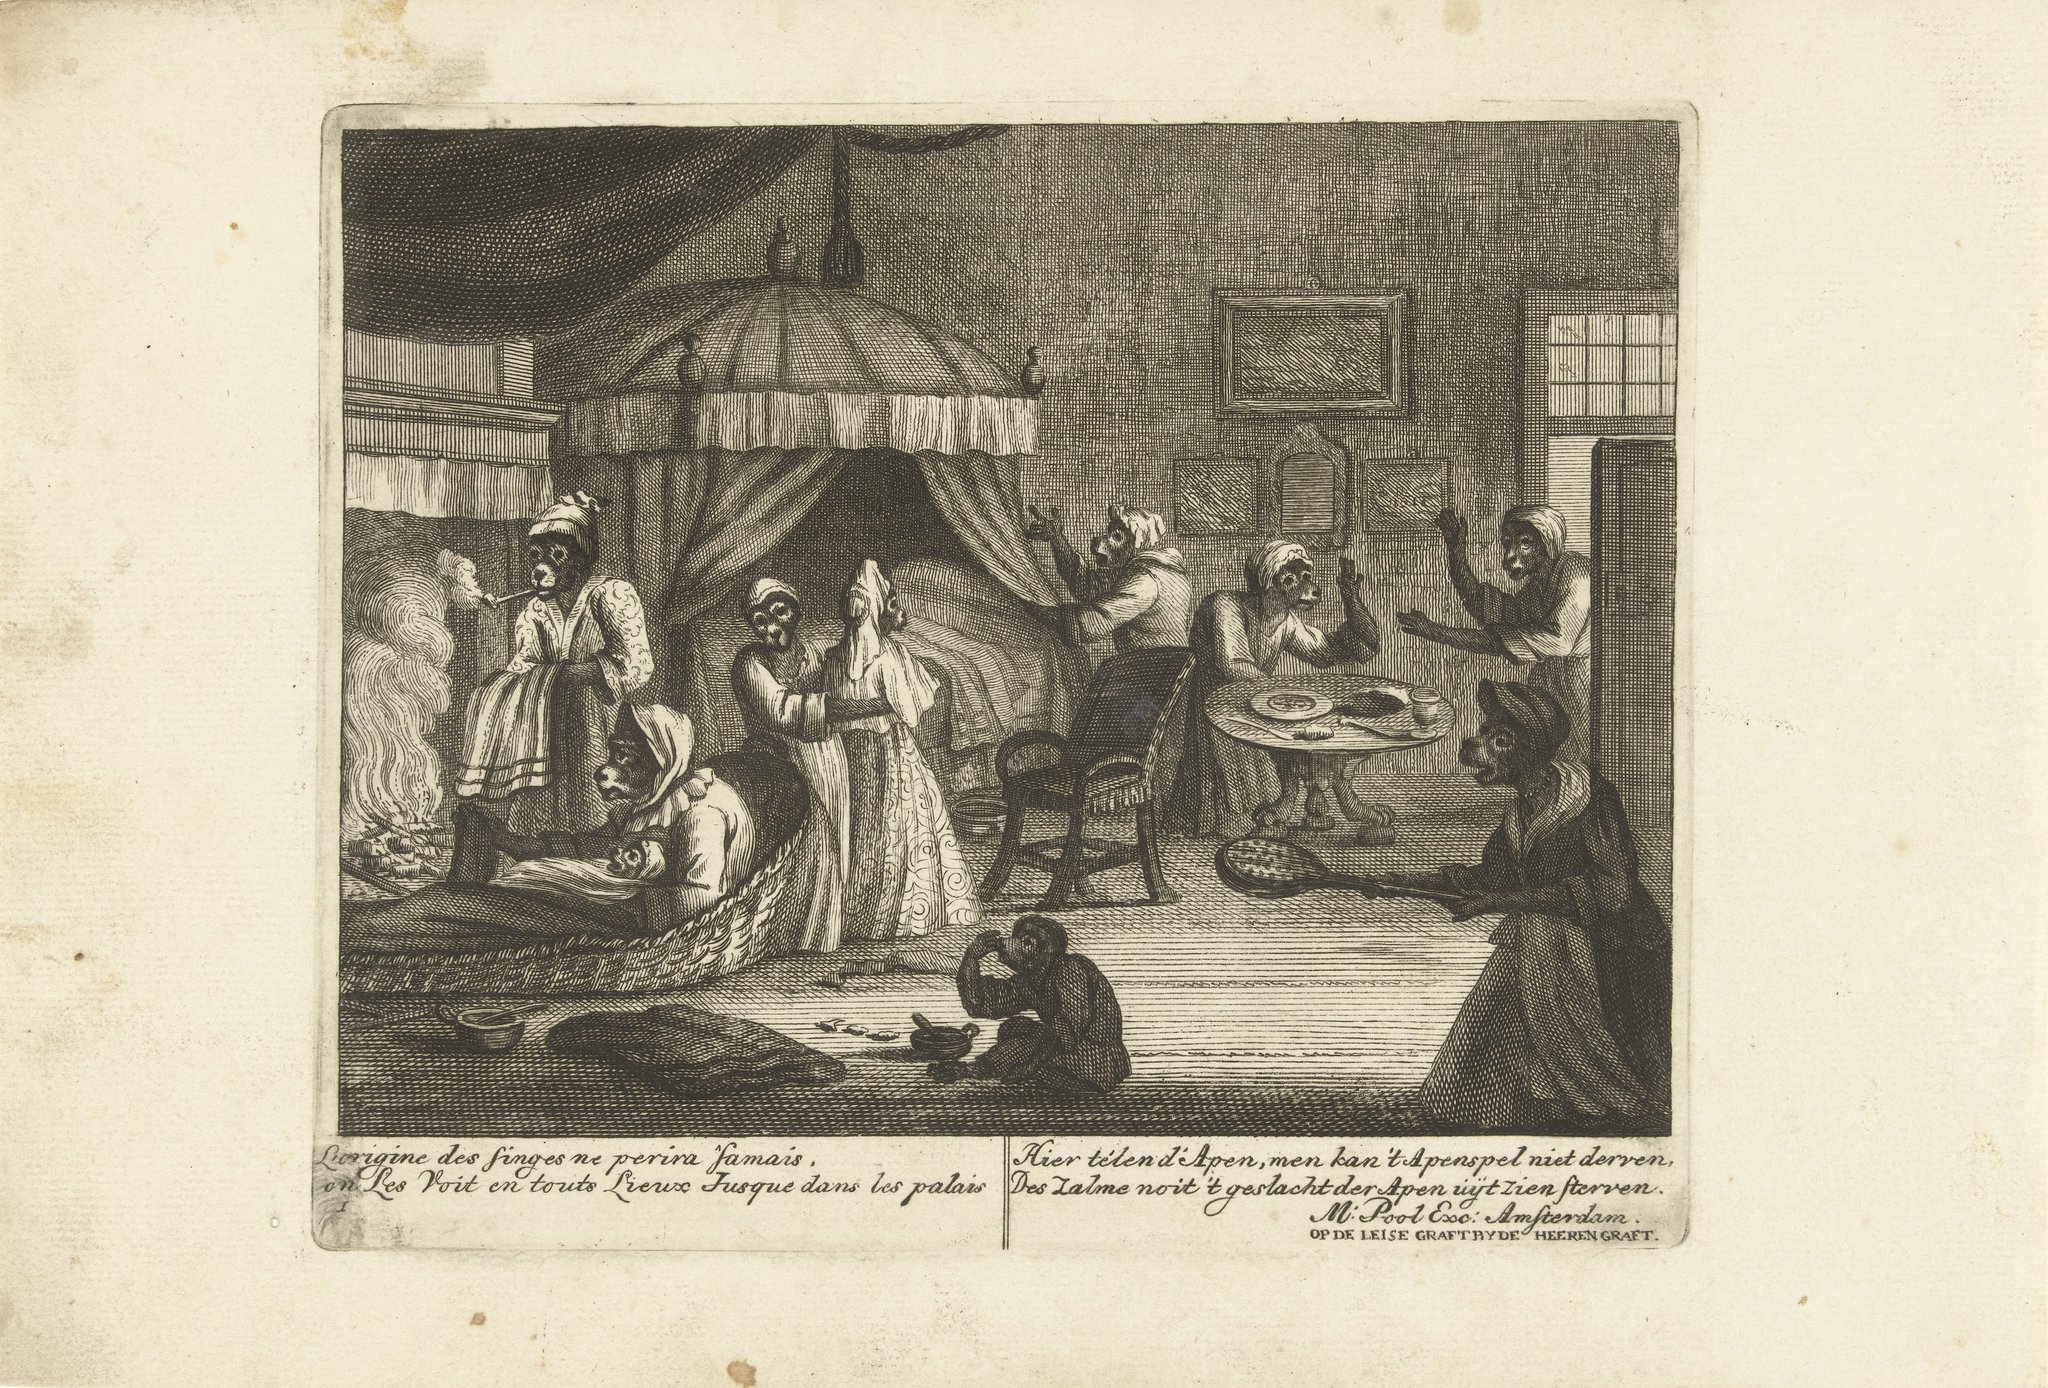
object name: print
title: Kraamkamer van de apen, ca. 1720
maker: matthijs pool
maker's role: print maker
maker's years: 1676-1740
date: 1720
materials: paper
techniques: engraving, etching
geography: amsterdam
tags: monkeys, apes, animals acting as human beings, lying-in room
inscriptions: collector's mark: Lugt 2228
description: De kraamkamer van de apen, met voedvrouw, moeder en het pasgeboren aapje. In het onderschrift versjes in het Frans en Nederlands. Prent nr. 1 in een serie van 16 prenten van ca. 1720 waarin apen als mensen figureren in allerlei huishoudelijke taferelen.